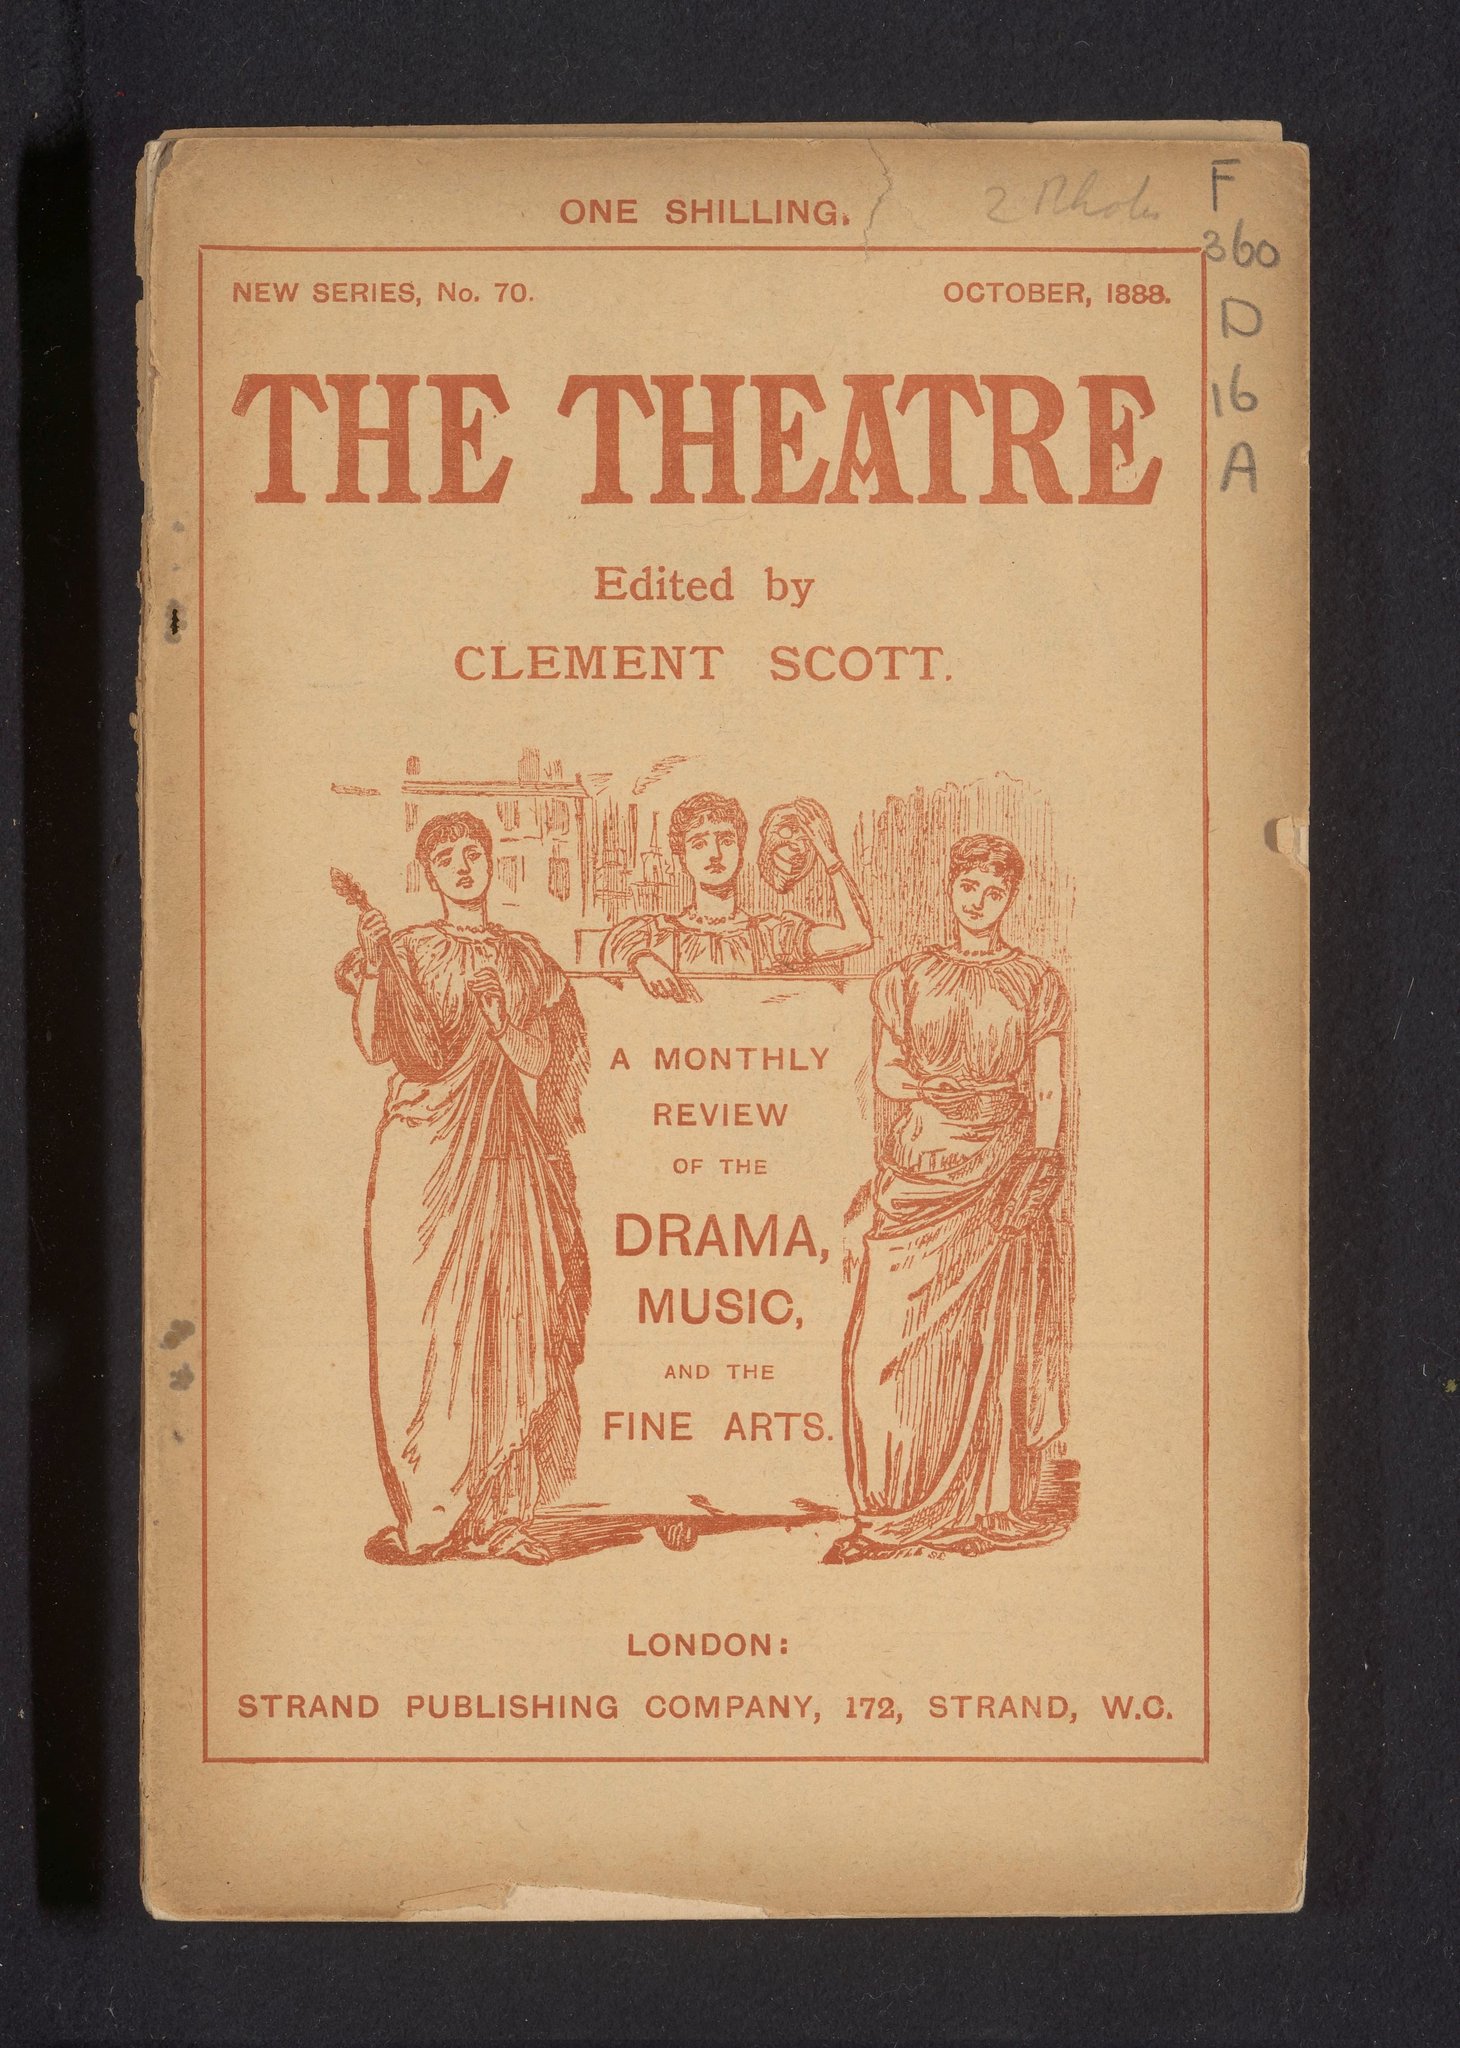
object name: magazine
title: The theatre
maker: clement scott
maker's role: redacteur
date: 1888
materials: paper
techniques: printing, woodburytype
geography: london